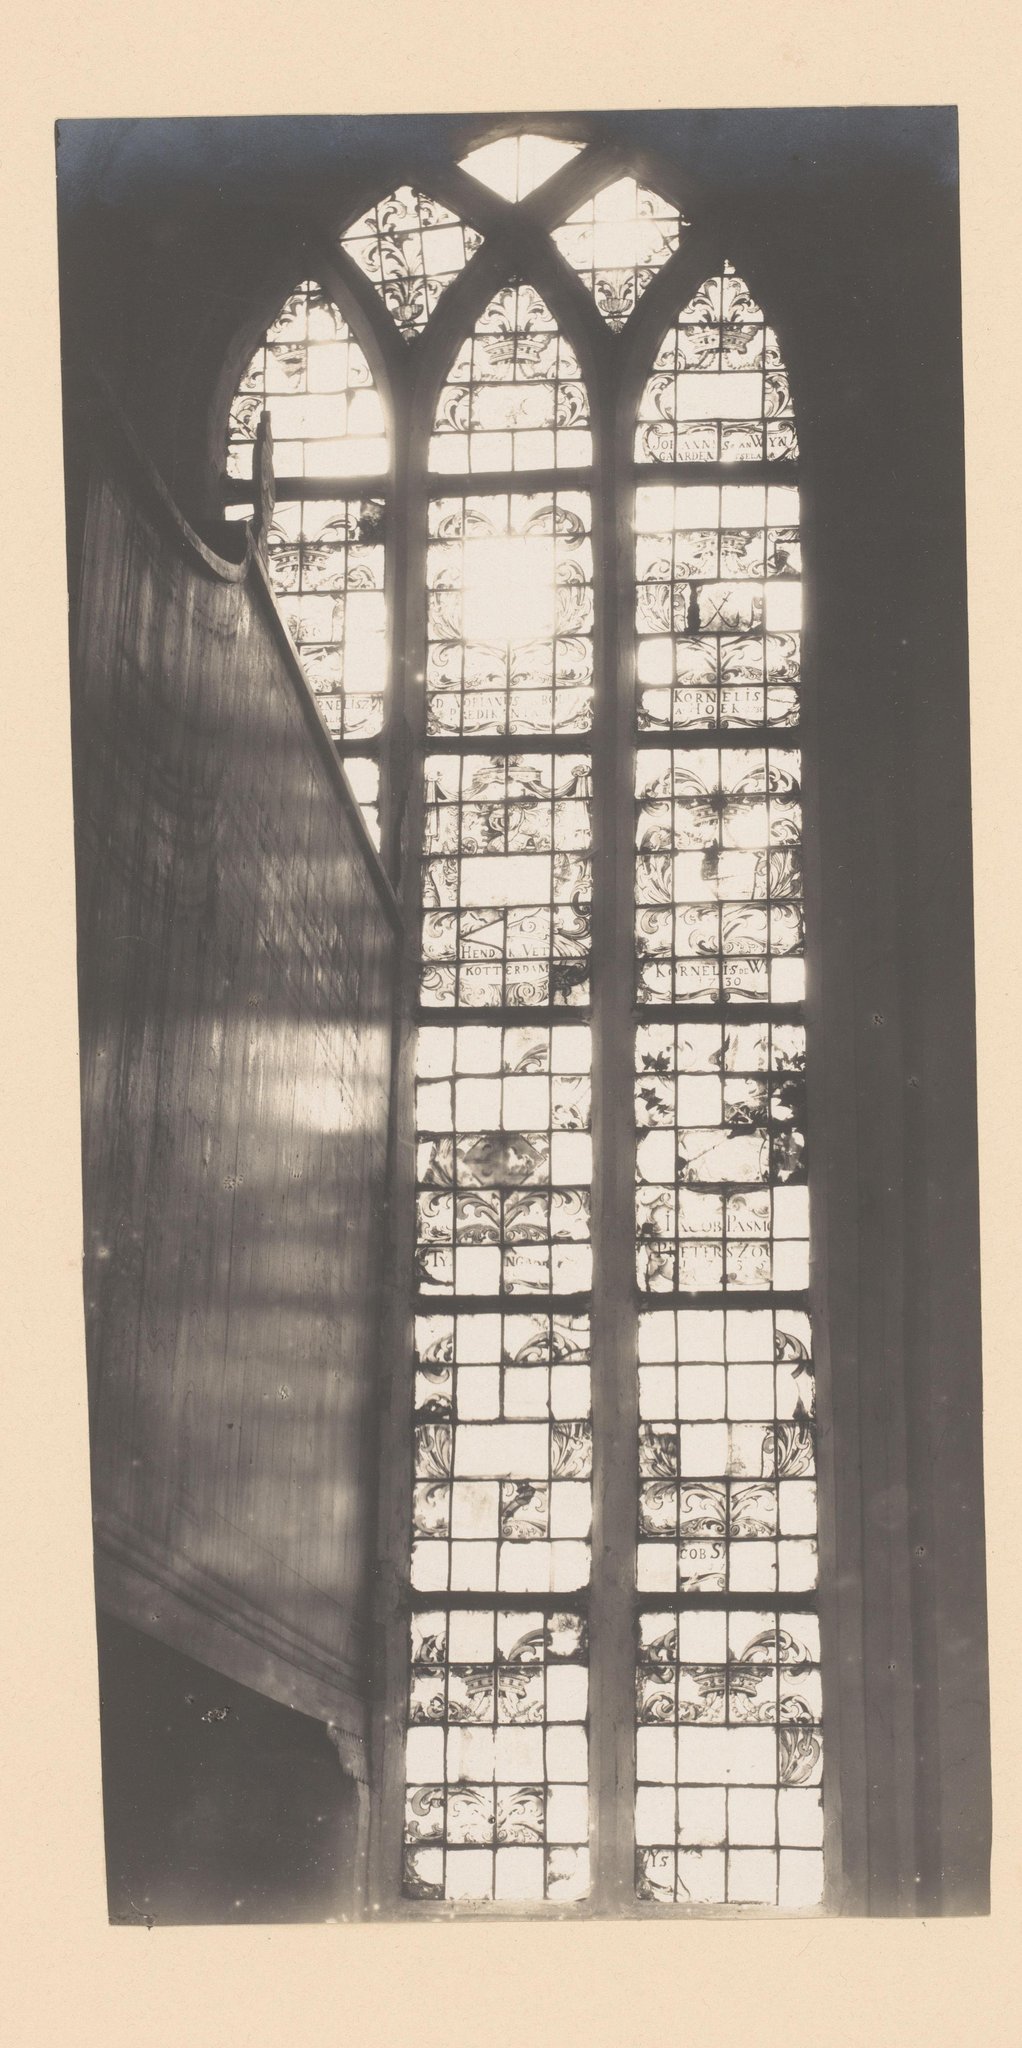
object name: photograph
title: Geschilderd raam van het schip in de Grote Kerk te Oosthuizen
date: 1910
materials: cardboard, photographic support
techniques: gelatin silver print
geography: grote kerk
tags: church-window, e.g. rose-window, interior of church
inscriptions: annotation: ‘E. de Jico/ Ca. 1570’, annotation: ‘b. Geschilderd raam in de Noordzije van het schip der N.H. Kerk, gezien van ui de Kerk. Aug 1910/ (zie ook b)/ Oosthuizen’